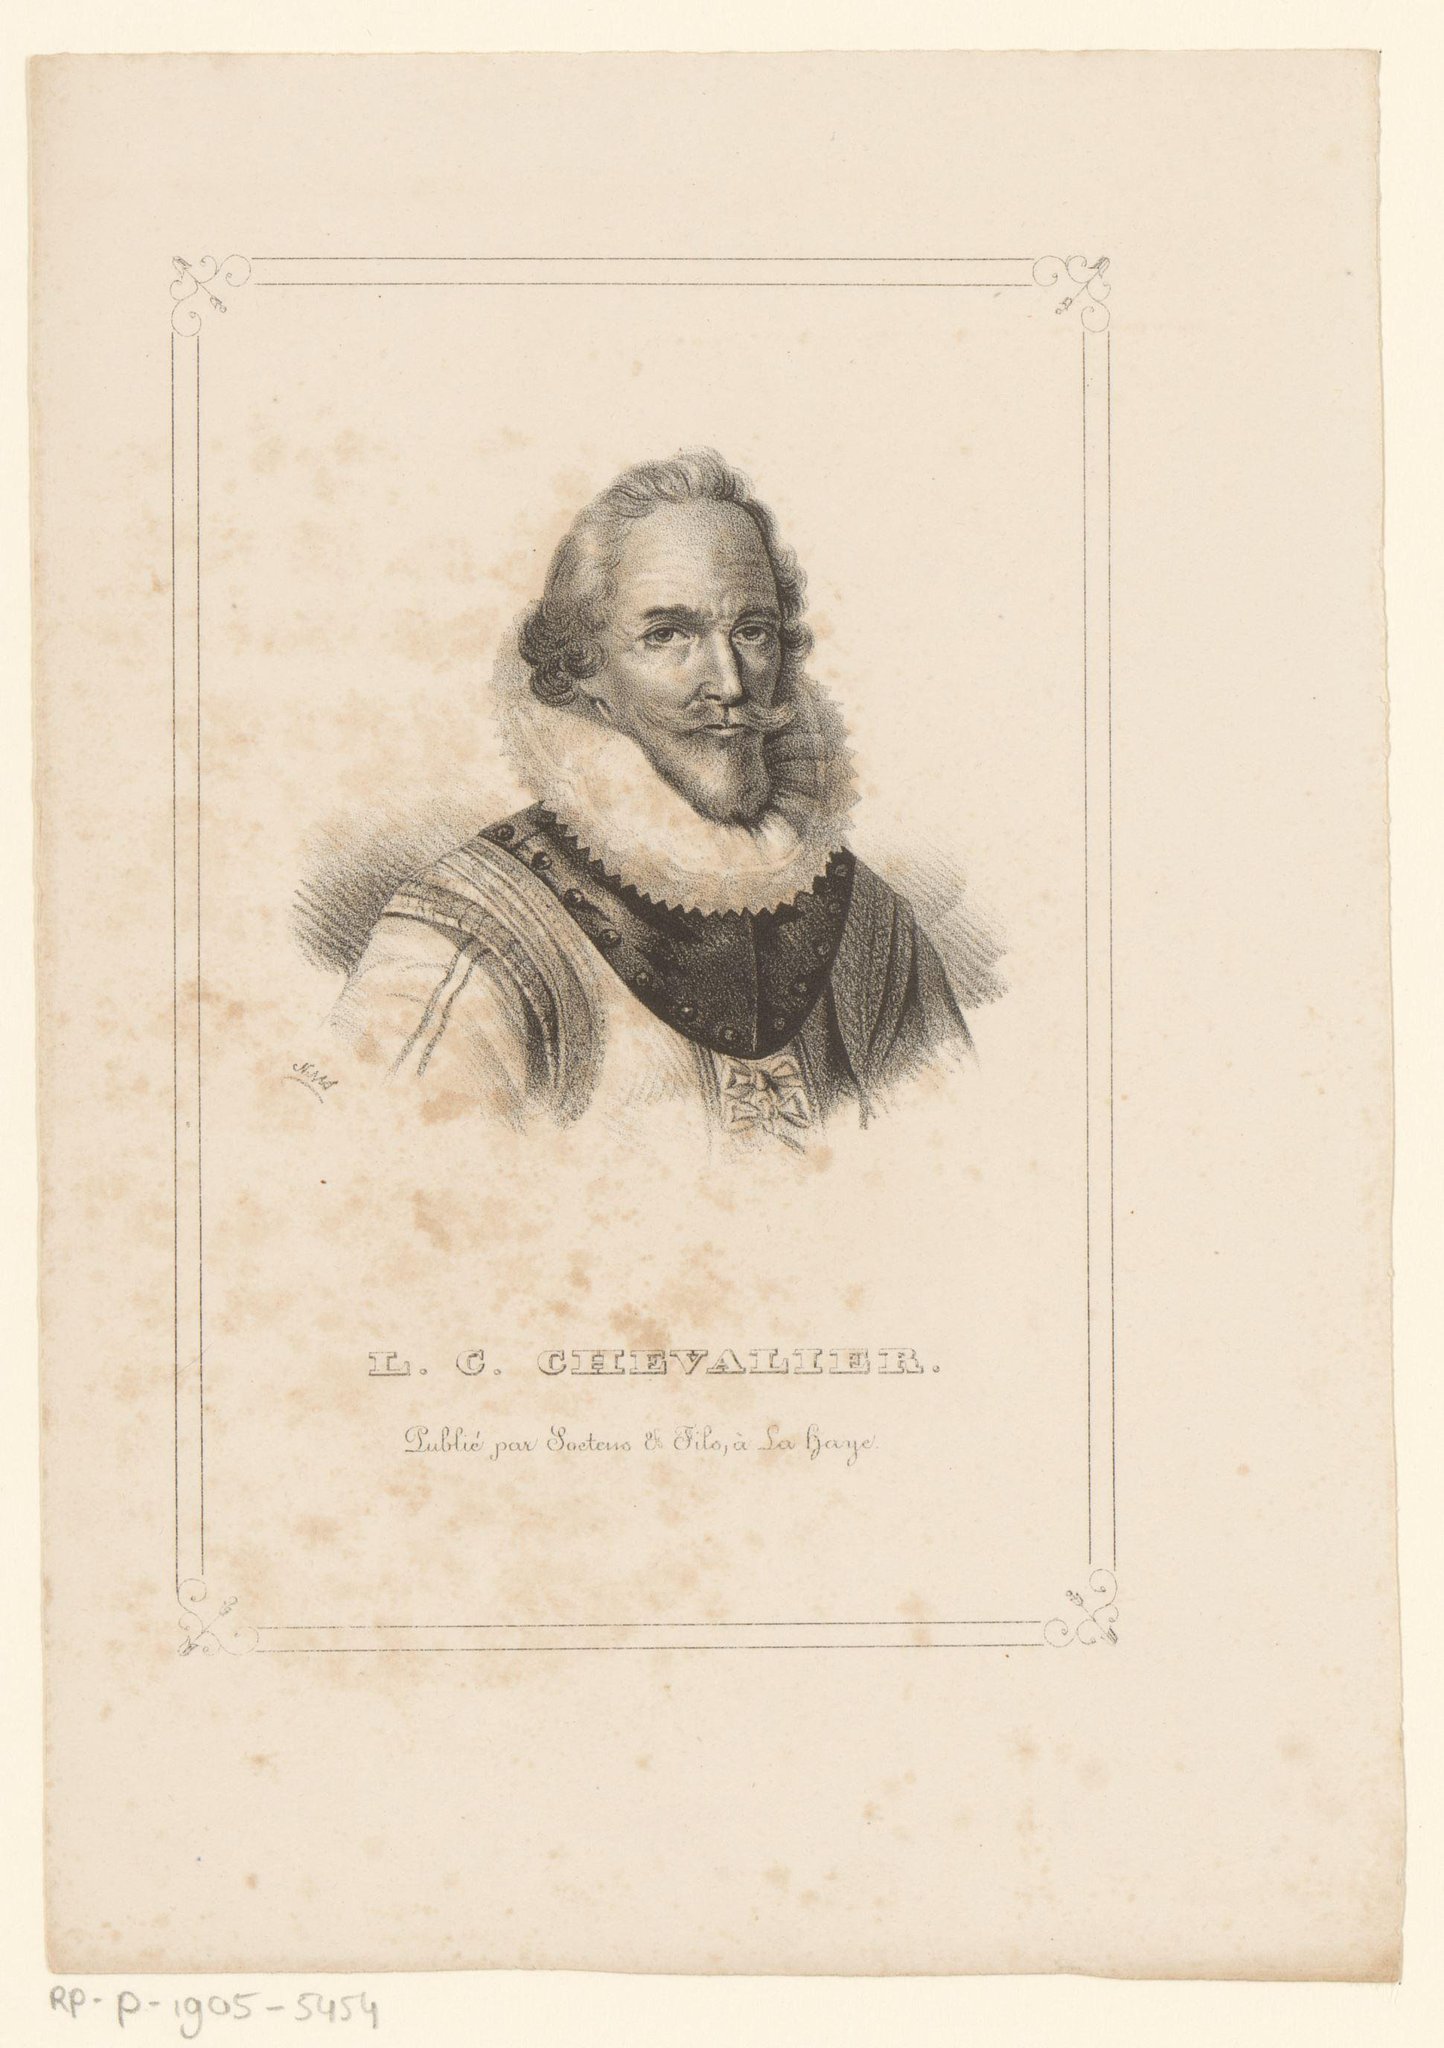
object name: print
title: Portret van Lambert Charles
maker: nicolaas martinus schild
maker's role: draughtsman, print maker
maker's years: 1822-1840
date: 1837-1840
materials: paper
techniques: lithograph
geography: the hague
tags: historical persons (+ (full) bust portrait)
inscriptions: collector's mark: Lugt 2228